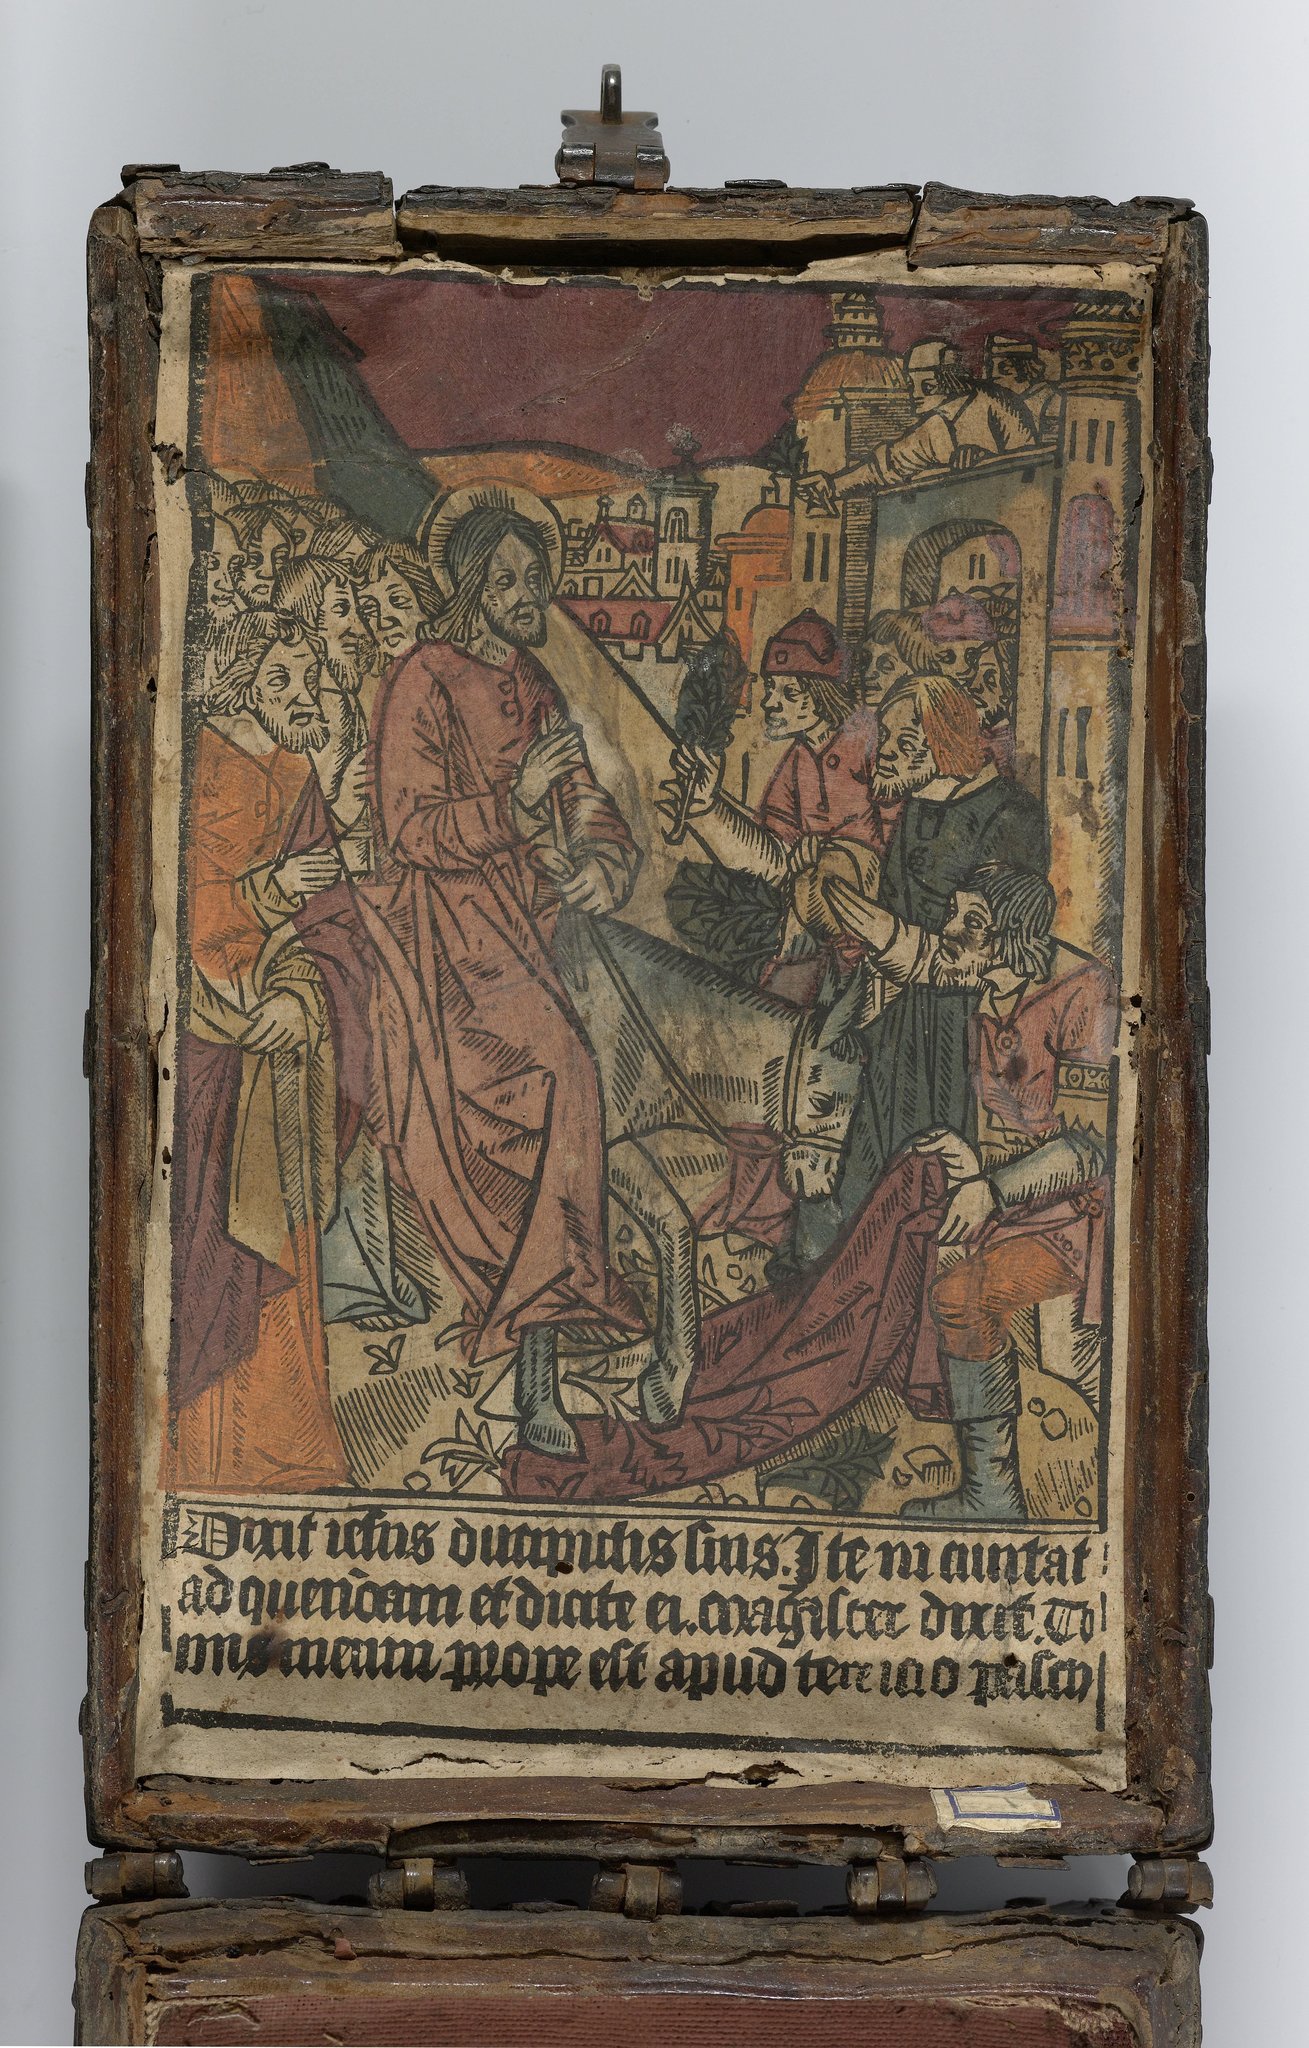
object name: case furniture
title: Kist met een ingekleurde houtsnede met Intocht in Jerusalem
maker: Anonymous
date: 1490-1510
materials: iron, linen, wood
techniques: woodcut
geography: france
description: Kist van hout, bekleed met zwart leer en voorzien van grof gesmede ijzeren met nagels bevestigde banden. Aan de voorzijde een slotplaat van ijzer met links en rechts opengewerkte vierkante vakken met een zuiltje (?). Op de binnenzijde van het deksel is een met sjablonen gekleurde houtsnede aangebracht met een voorstelling van de Intocht in Jerusalem. De binnenzijde is bekleed met rood linnen.